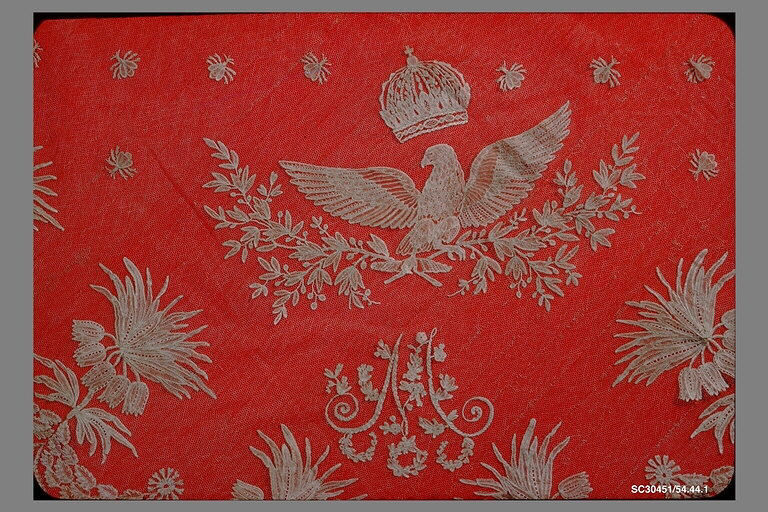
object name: veil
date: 1810-1814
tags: eagles,flowers